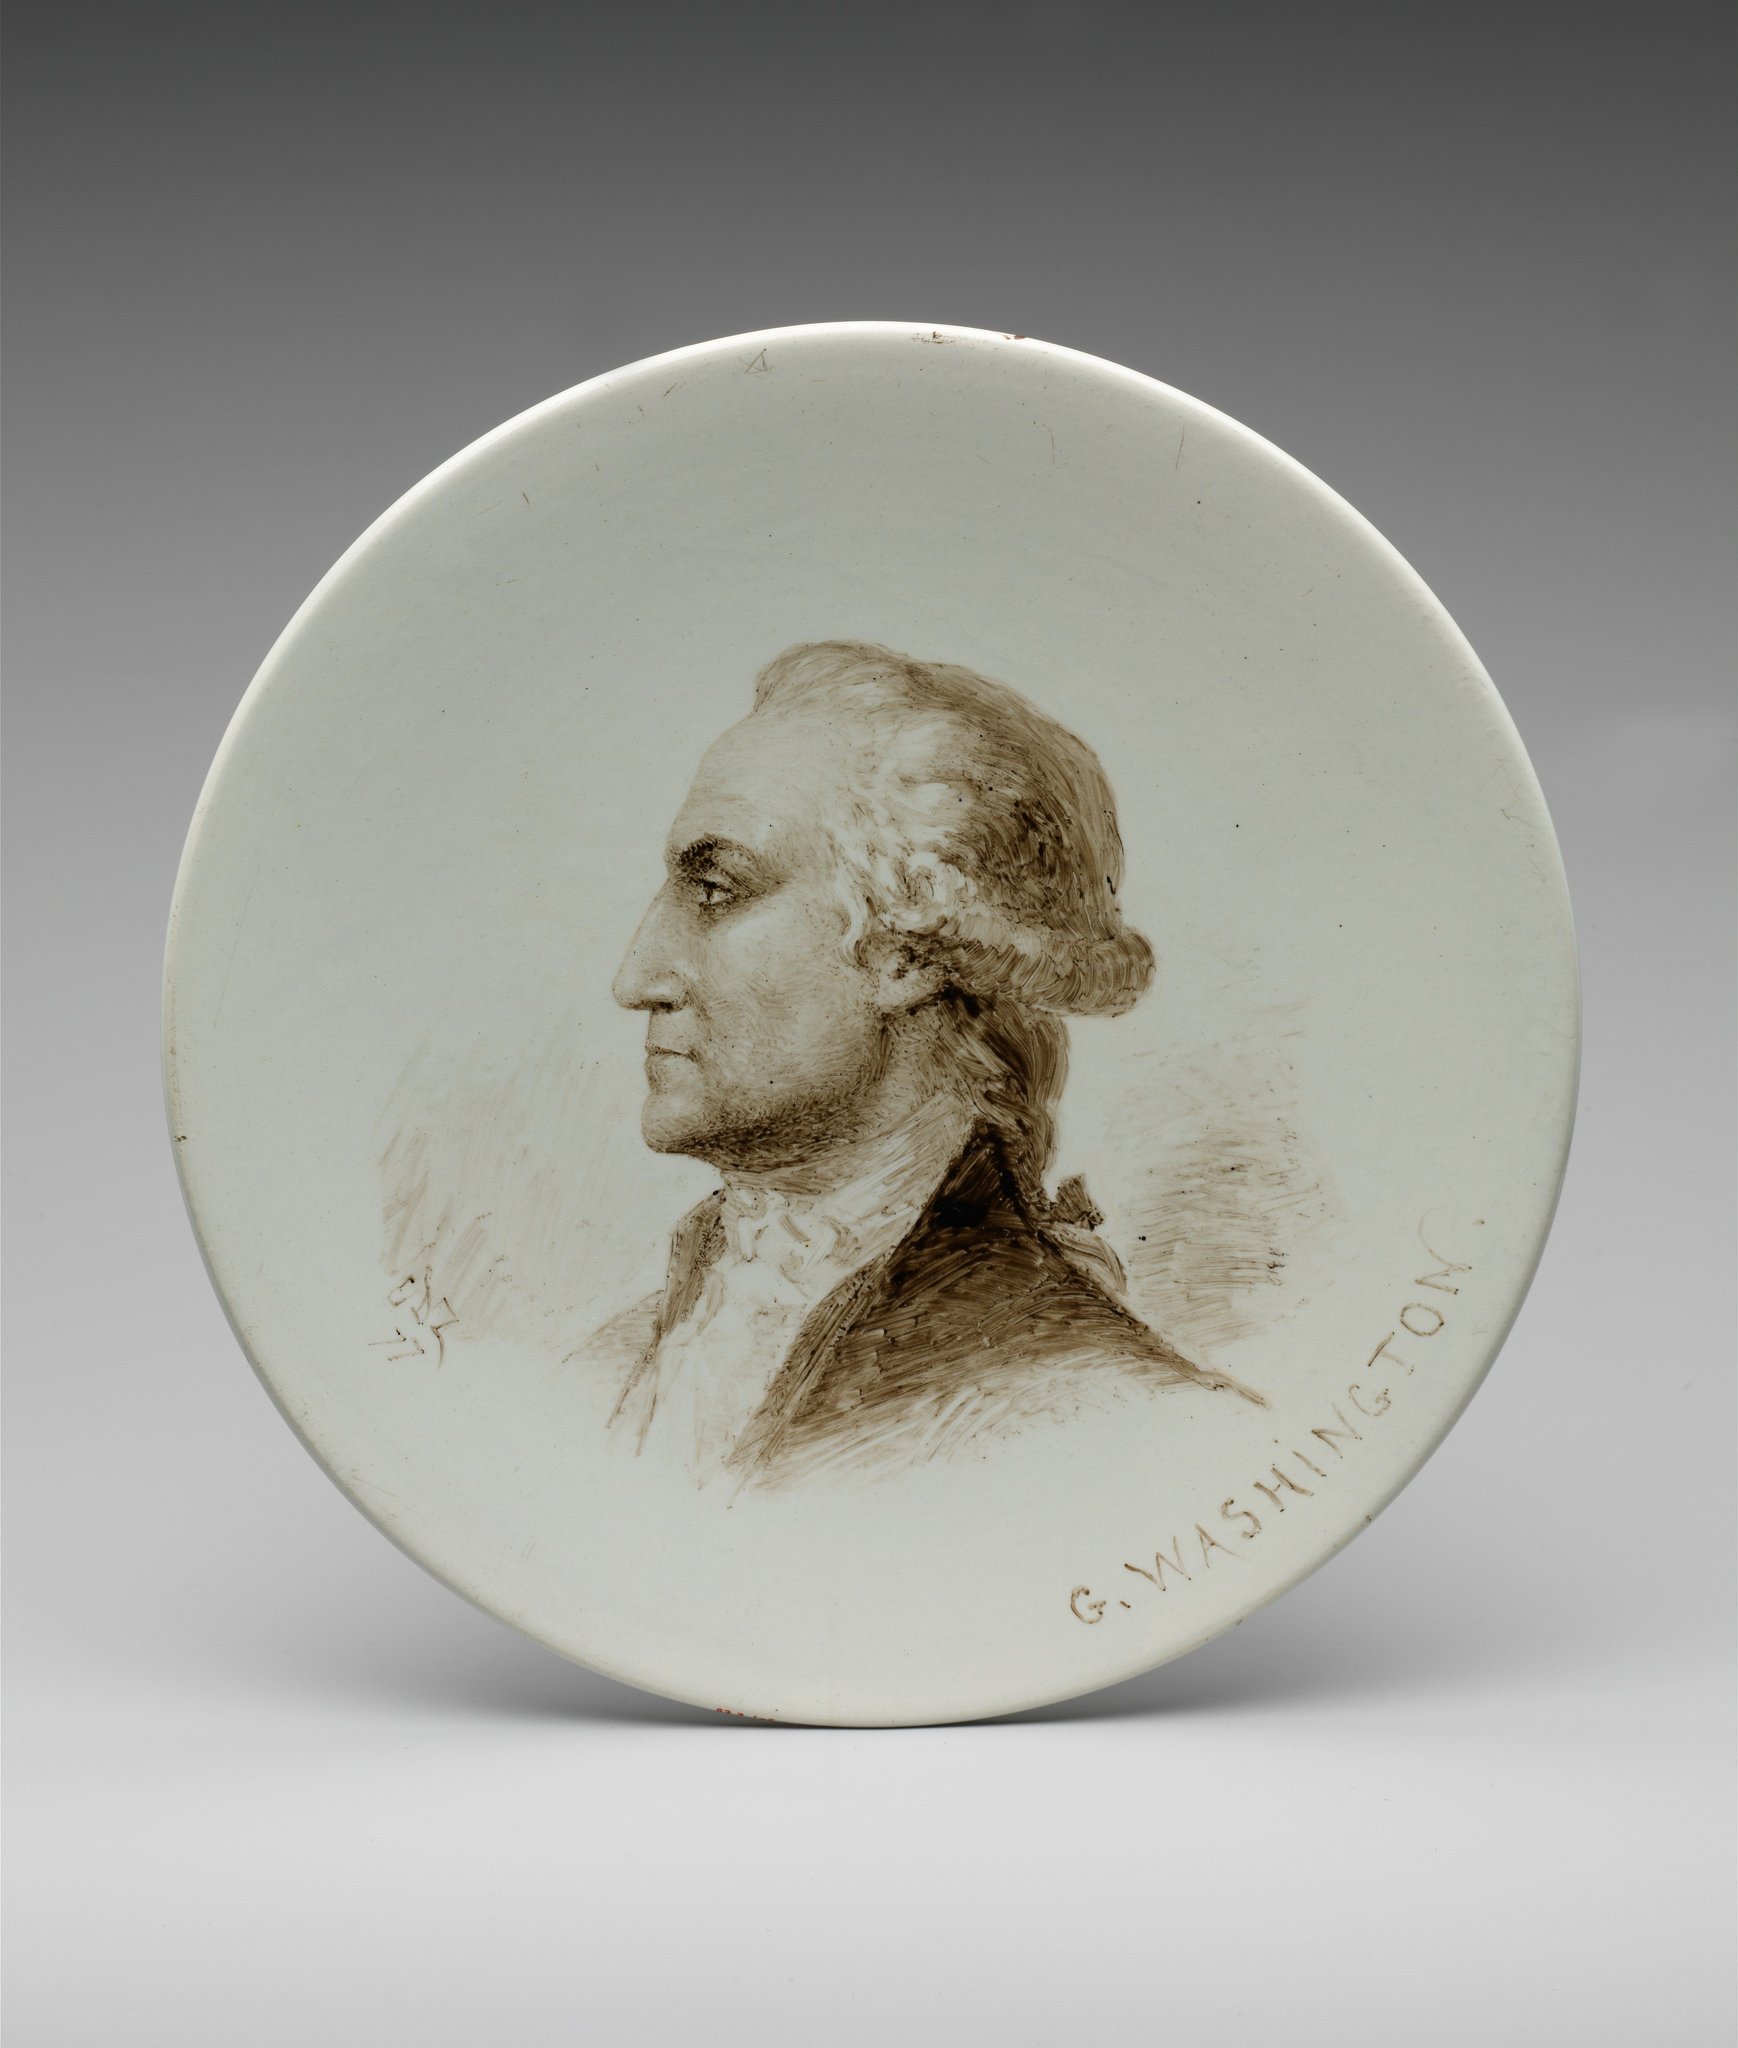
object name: plaque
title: George Washington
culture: french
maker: emile dupont-zipcy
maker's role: maker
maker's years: 1822-1885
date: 1840-1883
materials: faience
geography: france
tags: george washington,profiles